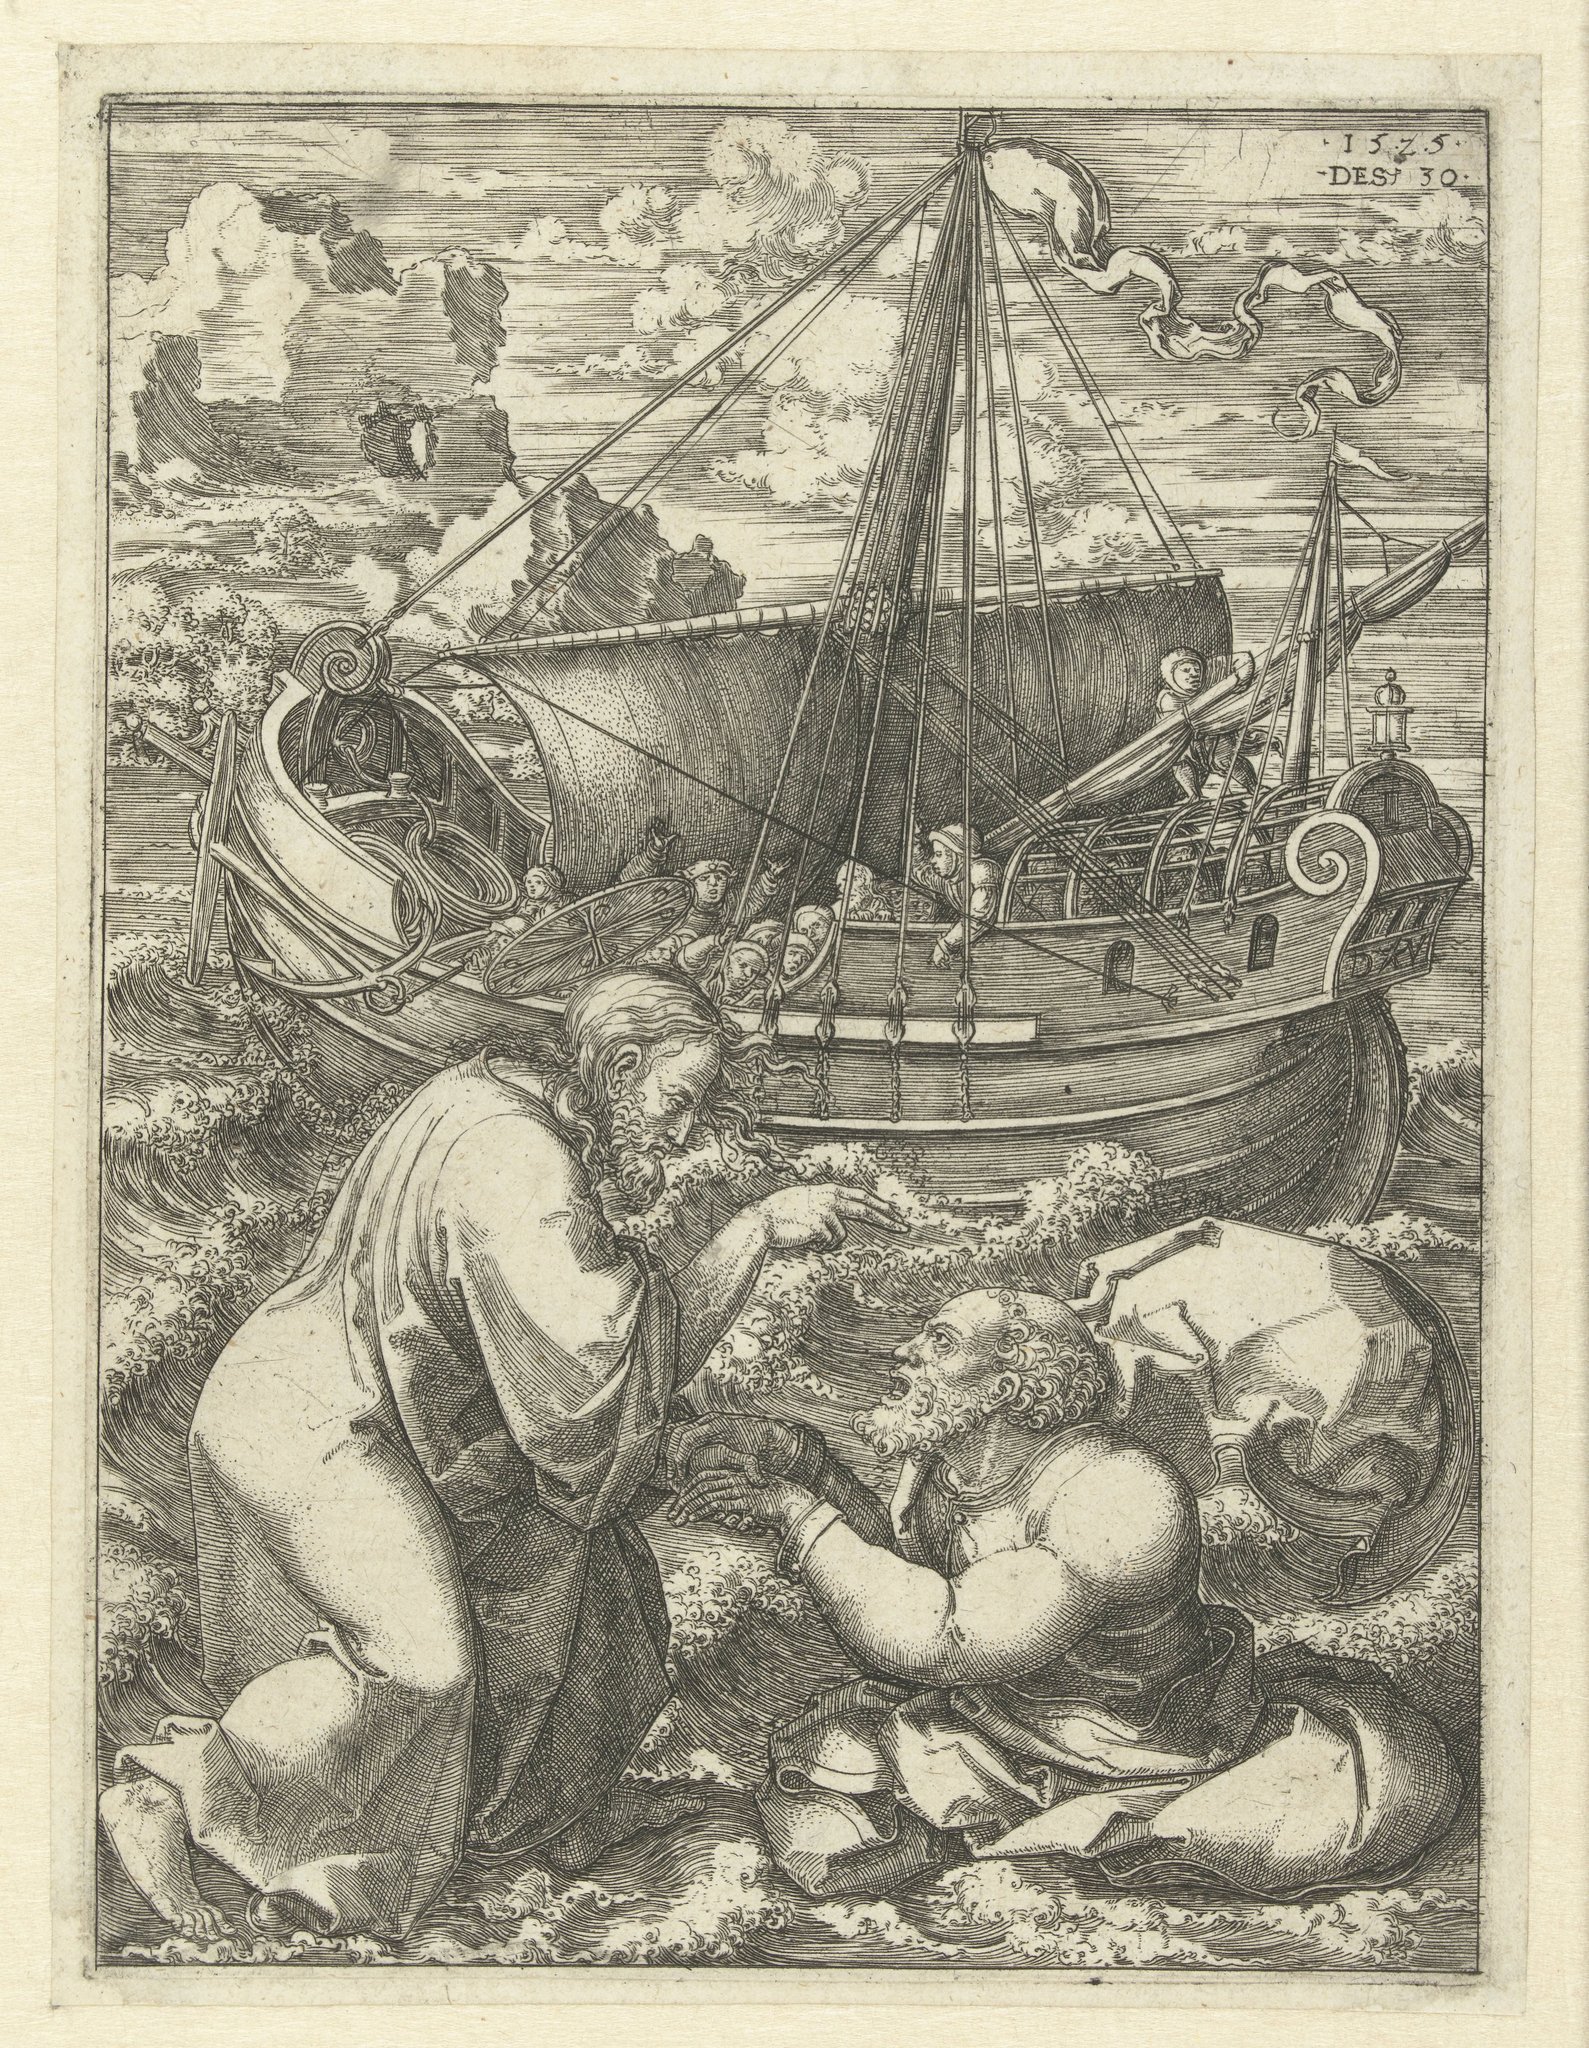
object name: print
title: Redding van Petrus door Christus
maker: dirck vellert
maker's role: draughtsman, painter, print maker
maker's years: 1480-1547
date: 1525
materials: paper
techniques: engraving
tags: christ saves peter from drowning, a storm arises; christ returns, walking on the water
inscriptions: collector's mark: Lugt 2228a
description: Stormachtige zee met schip, Christus lopend over water en Petrus tot middel in zee.